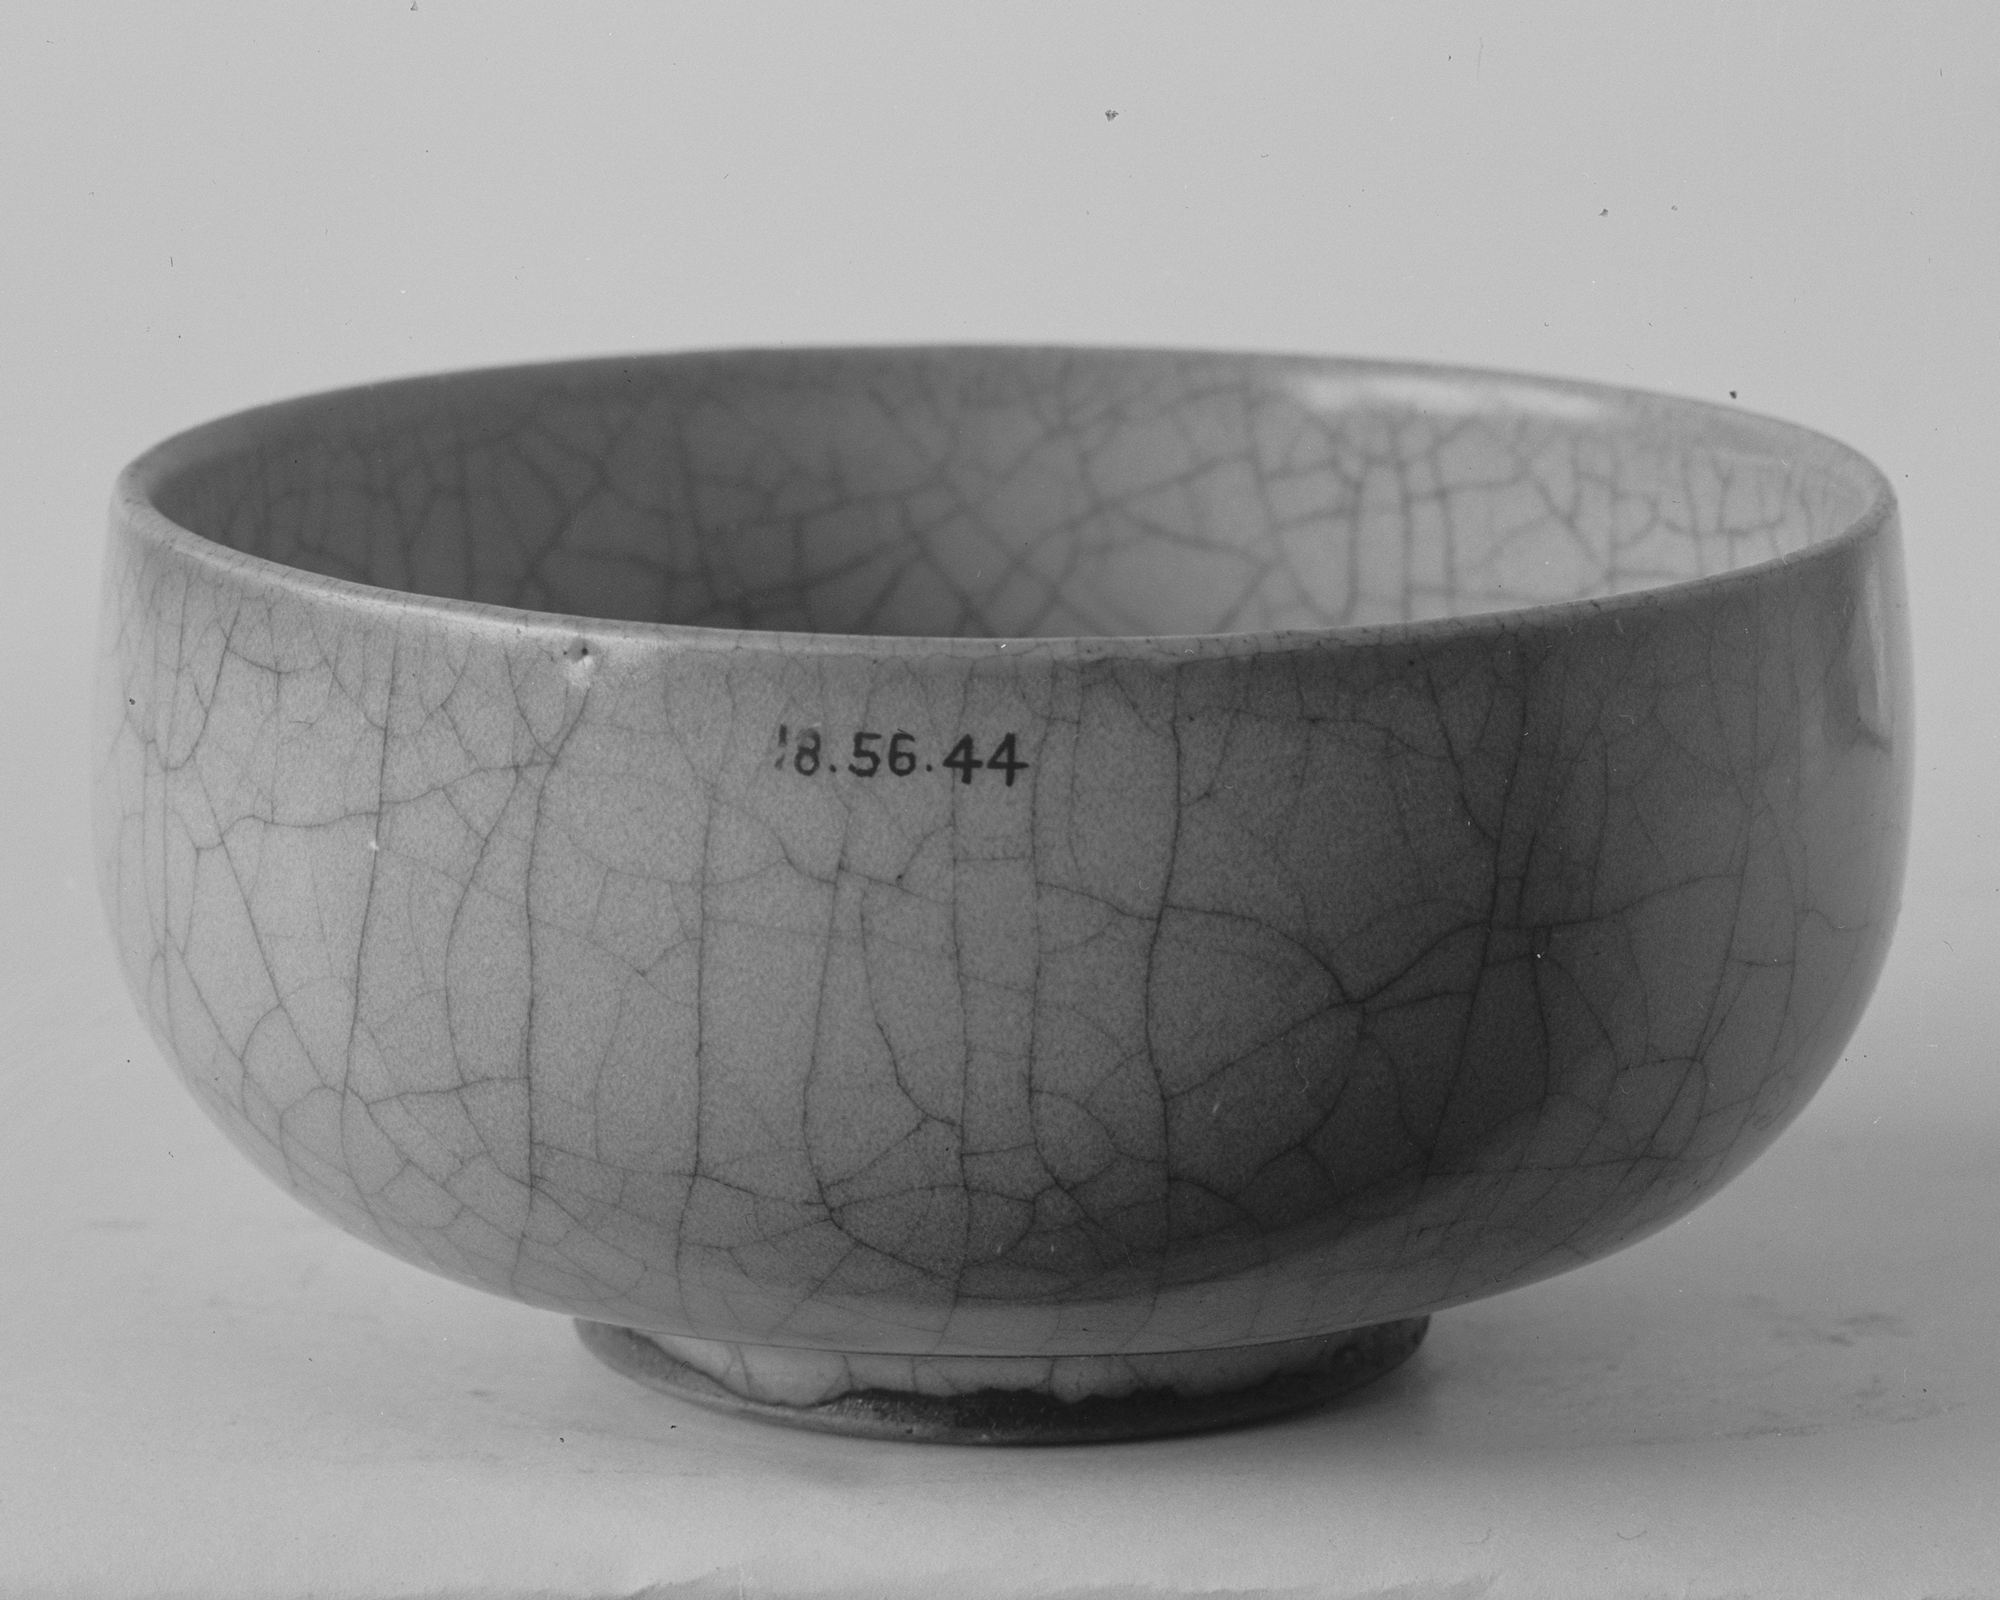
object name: bowl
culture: chinese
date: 1101-1300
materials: glaze, stoneware